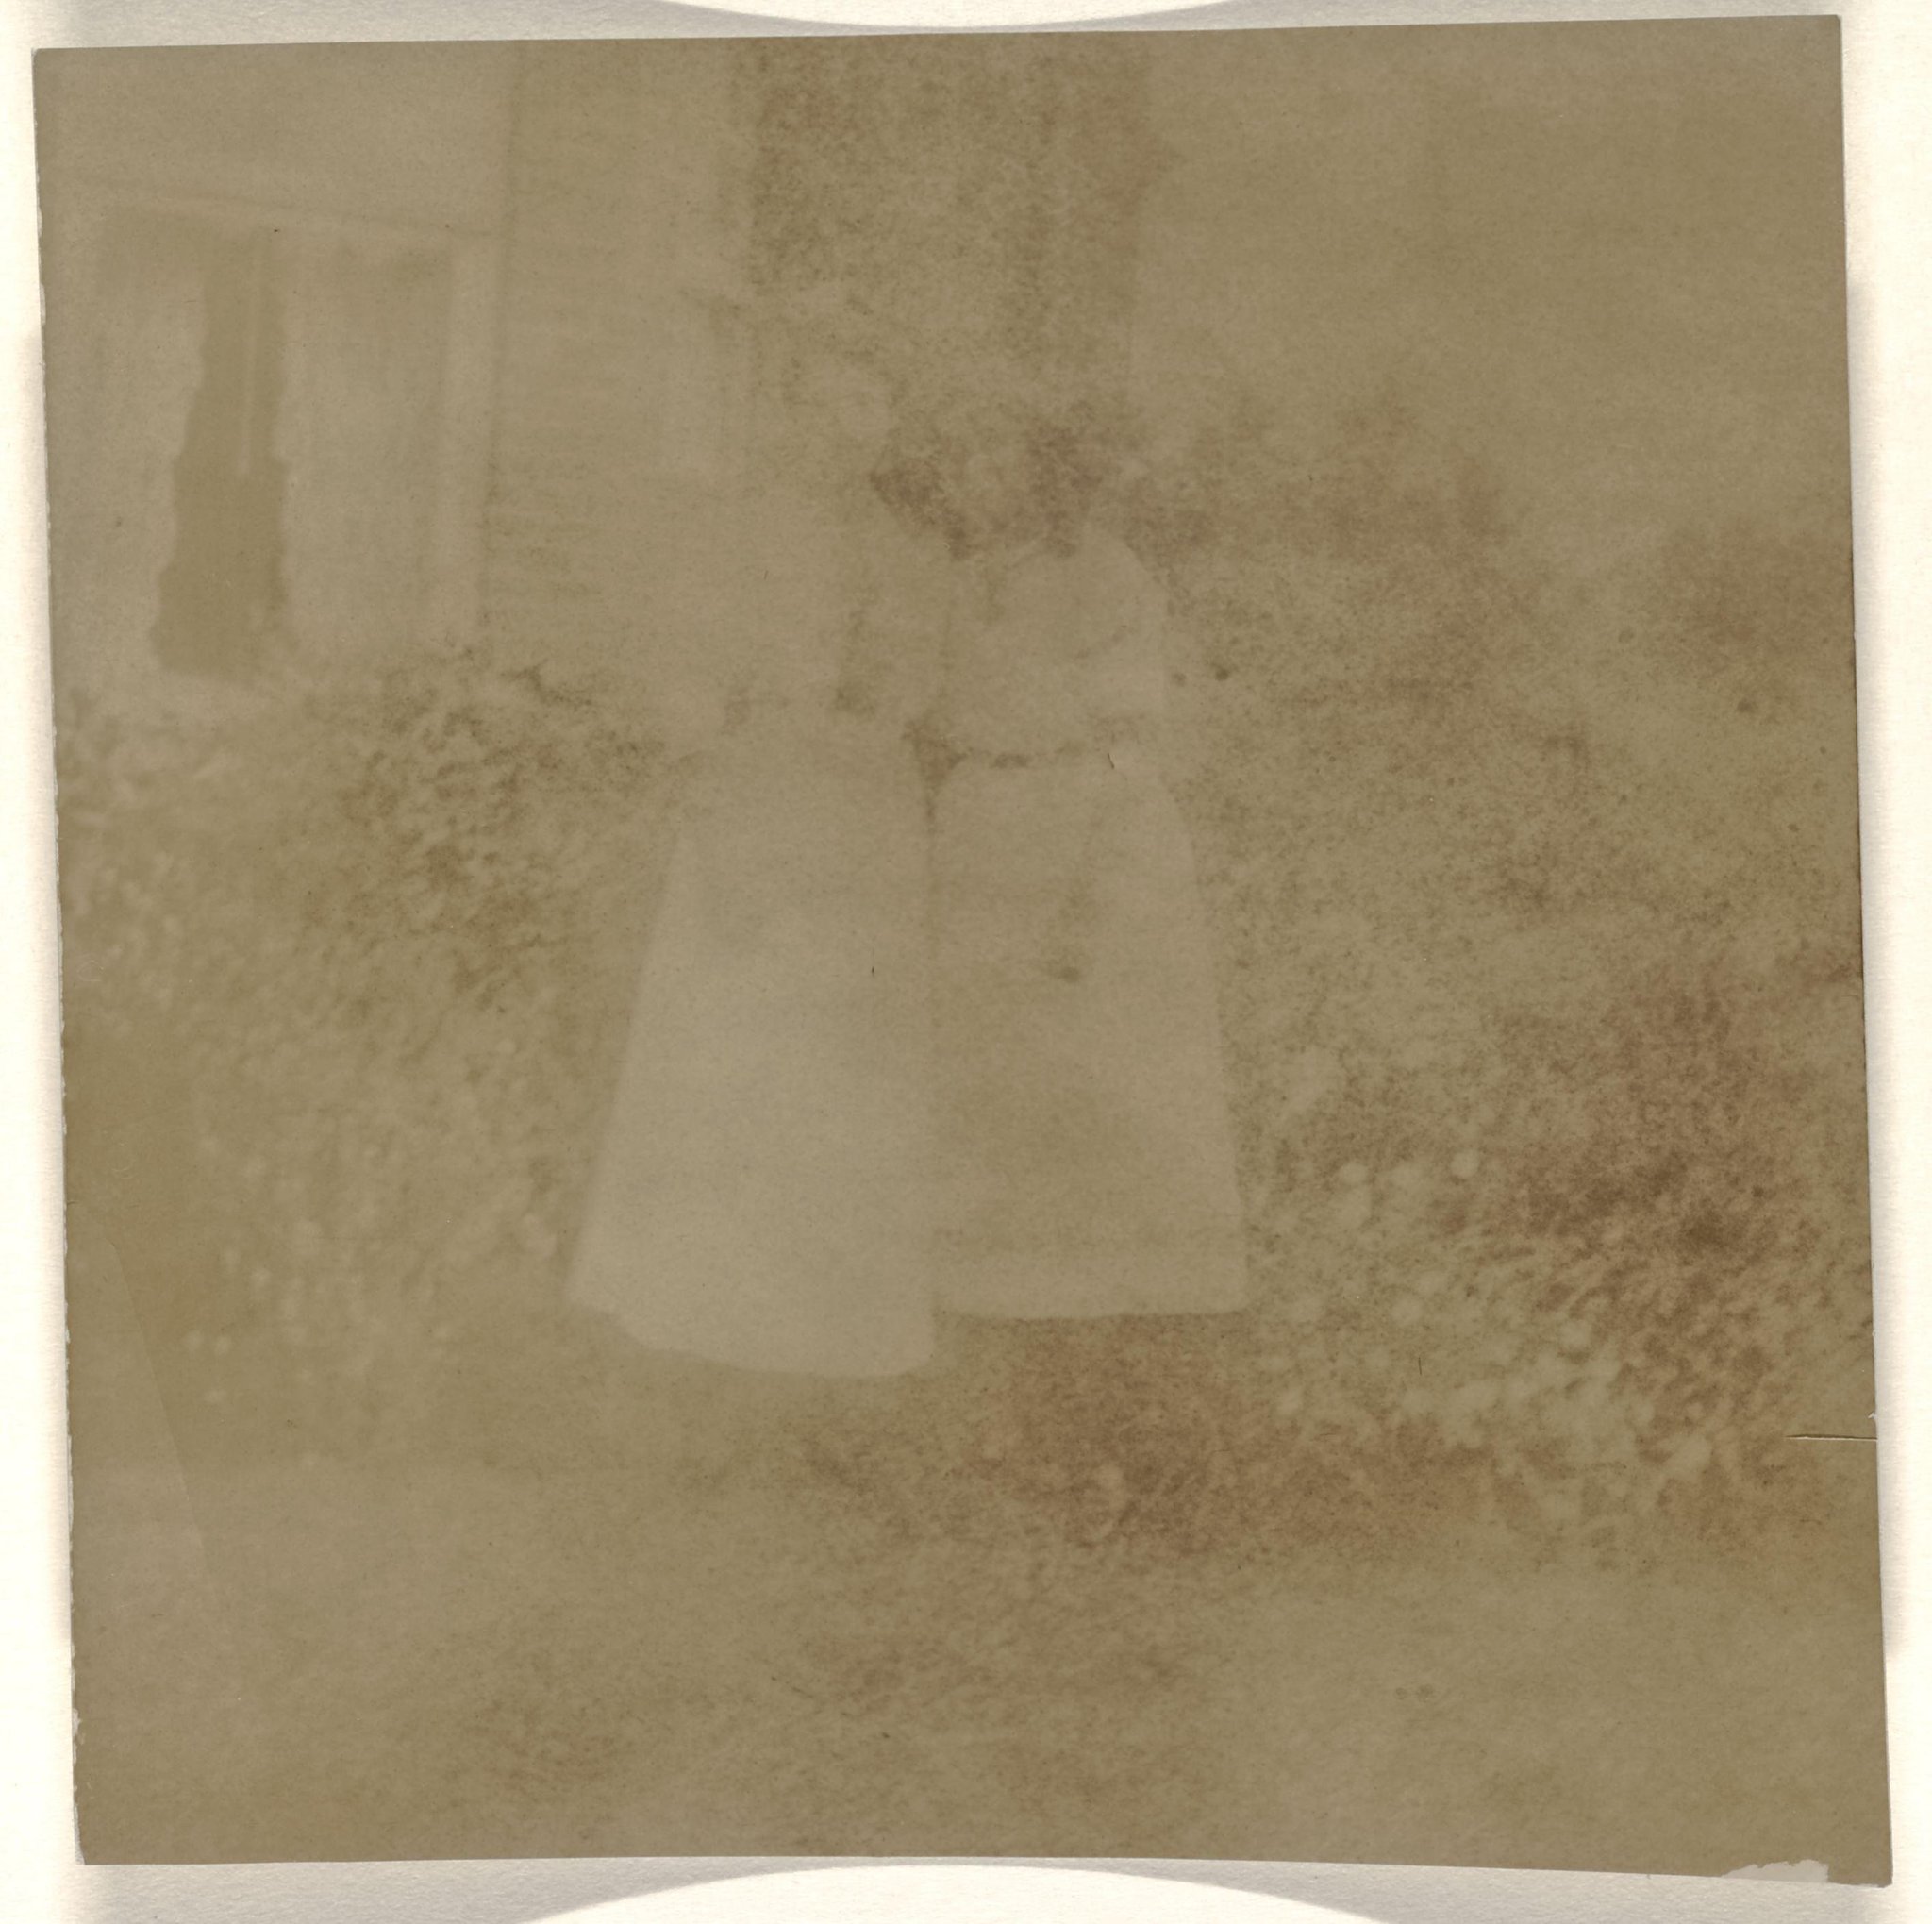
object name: photograph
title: Onscherpe foto van twee onbekende vrouwen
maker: Anonymous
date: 1880-1920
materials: photographic support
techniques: gelatin silver print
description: Onscherpe foto van twee onbekende vrouwen, met een haag en een gebouw met twee gordijnen in het raam op de achtergrond.